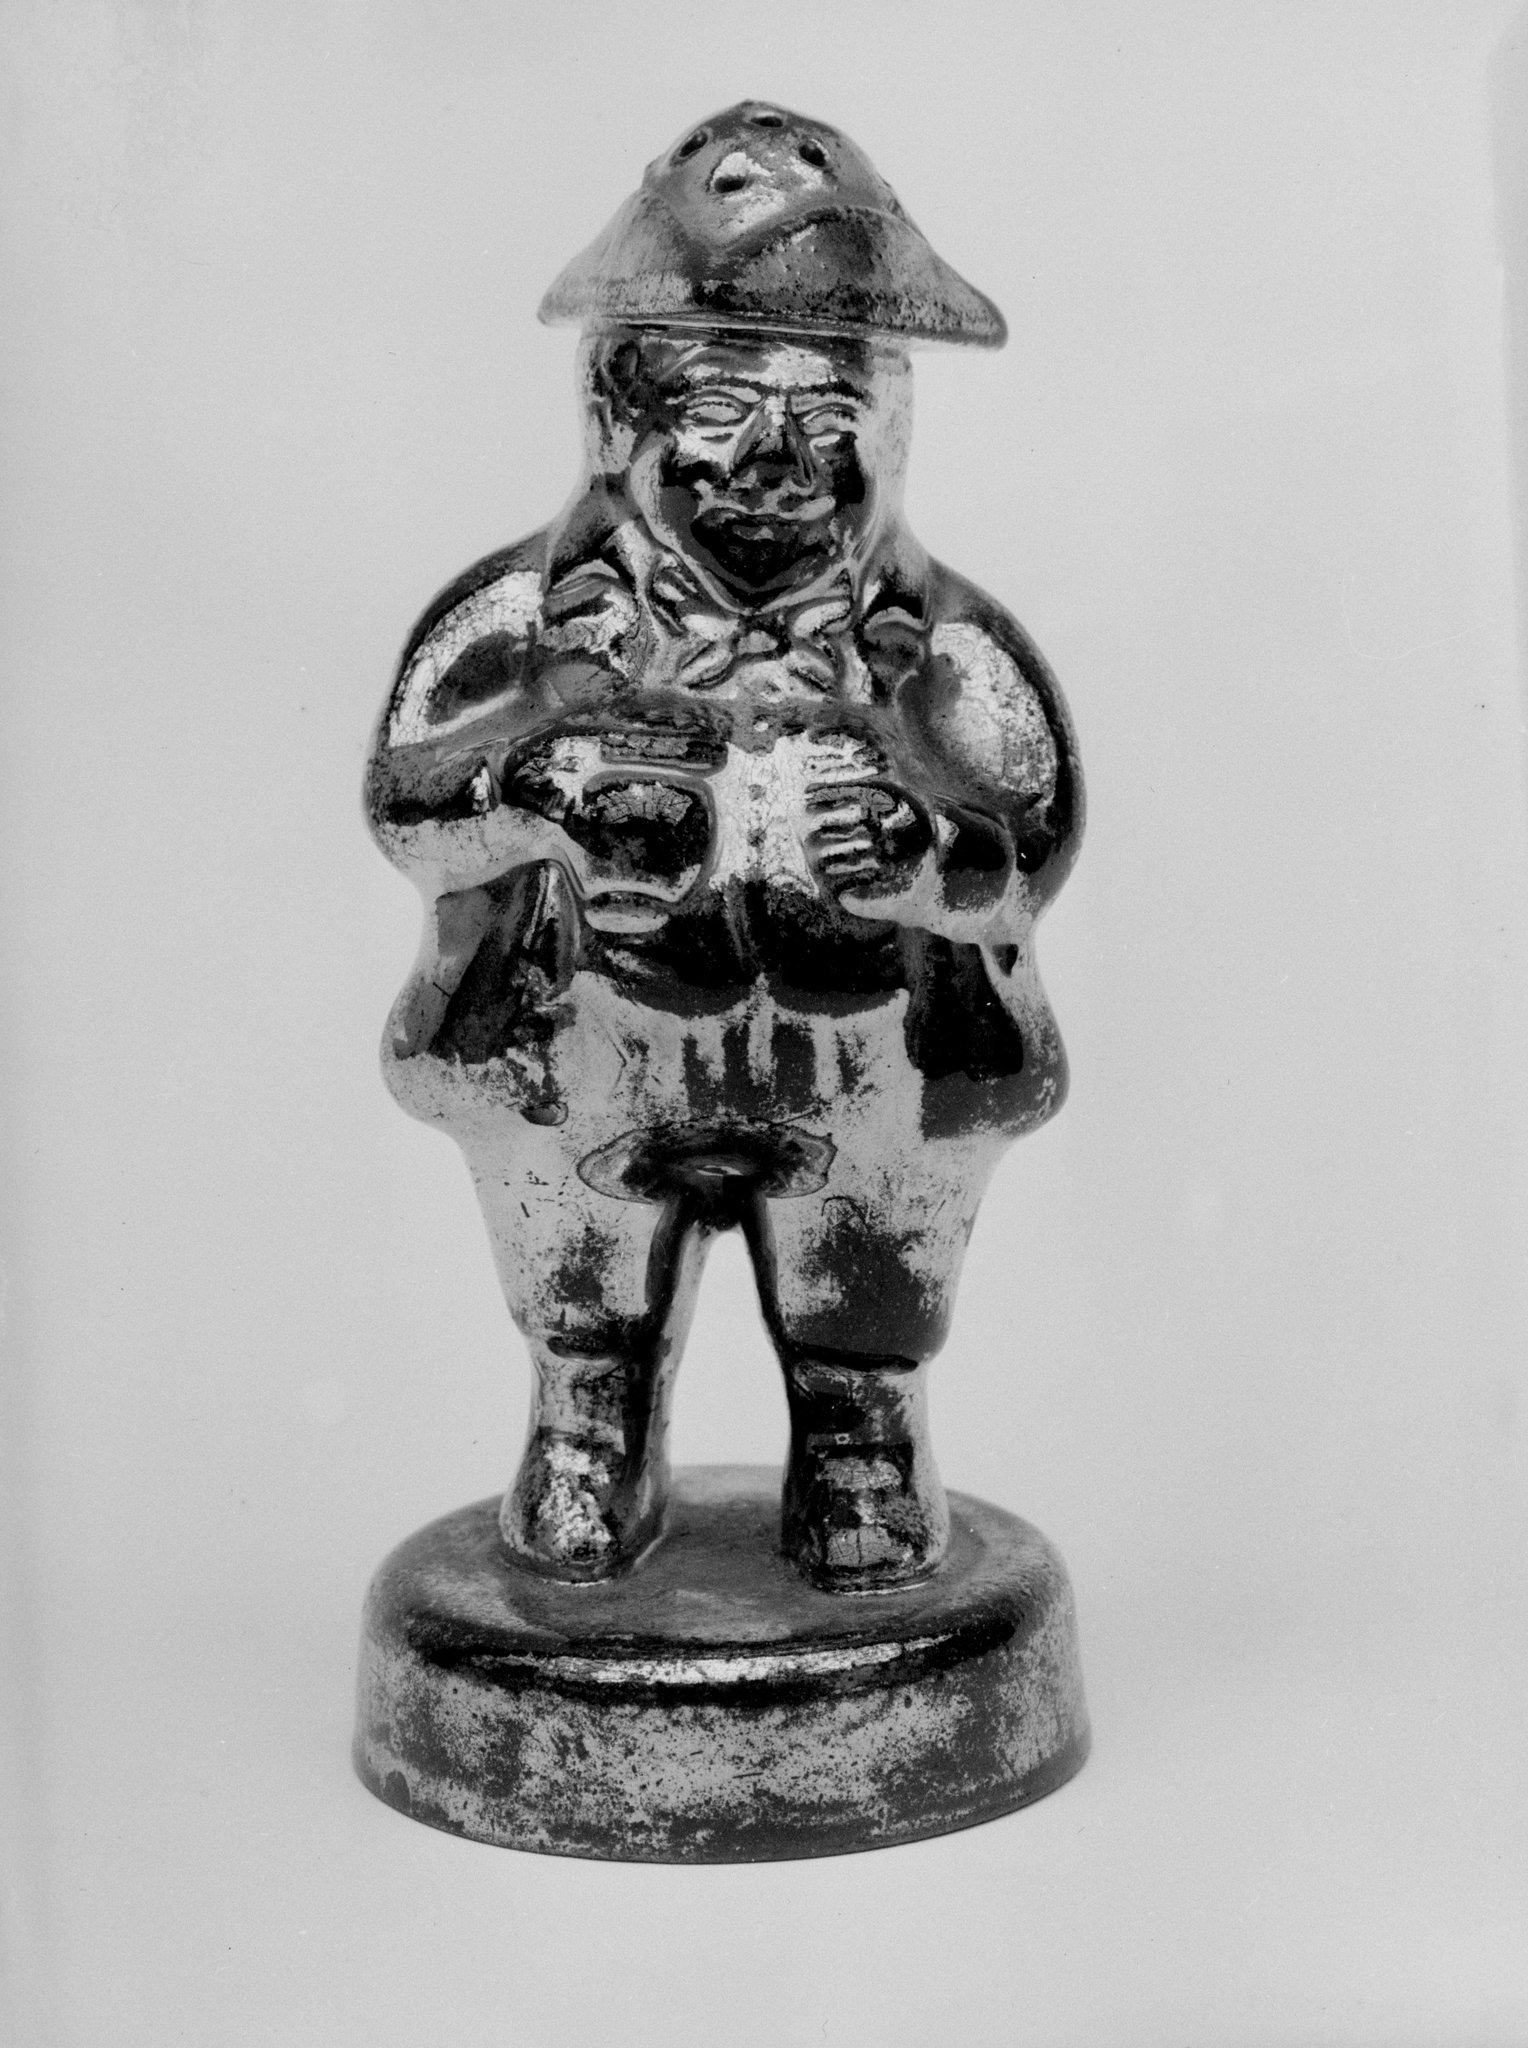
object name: caster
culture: british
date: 1800-1830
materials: earthenware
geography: england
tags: men